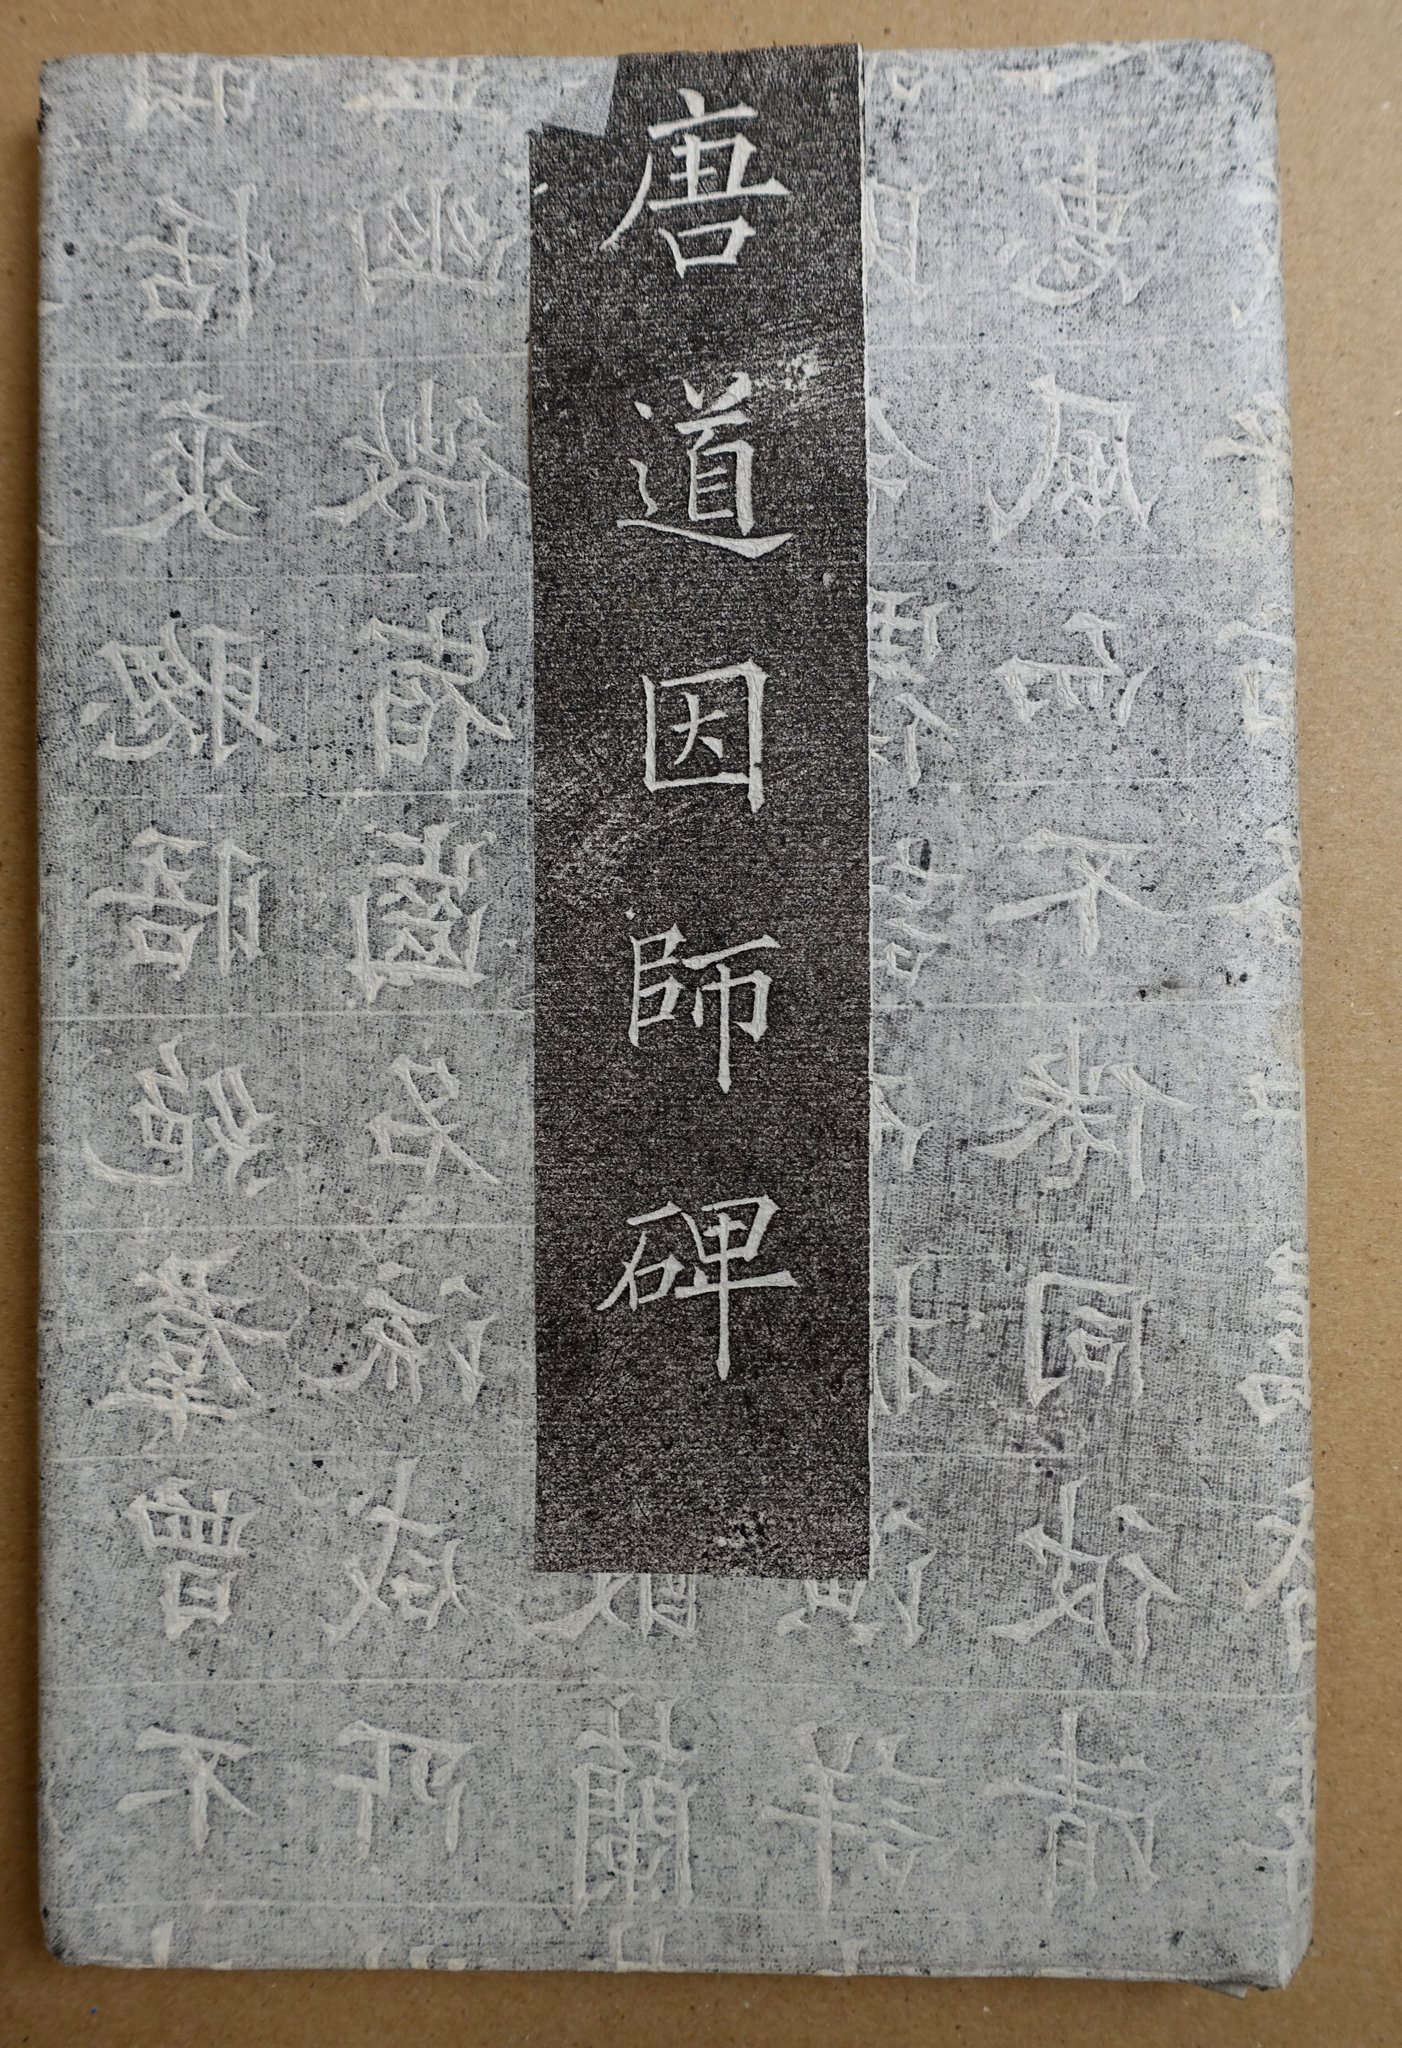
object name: rubbing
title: Epitaph for the Monk Daoyin (587-658)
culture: chinese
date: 1901-2000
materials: ink, paper